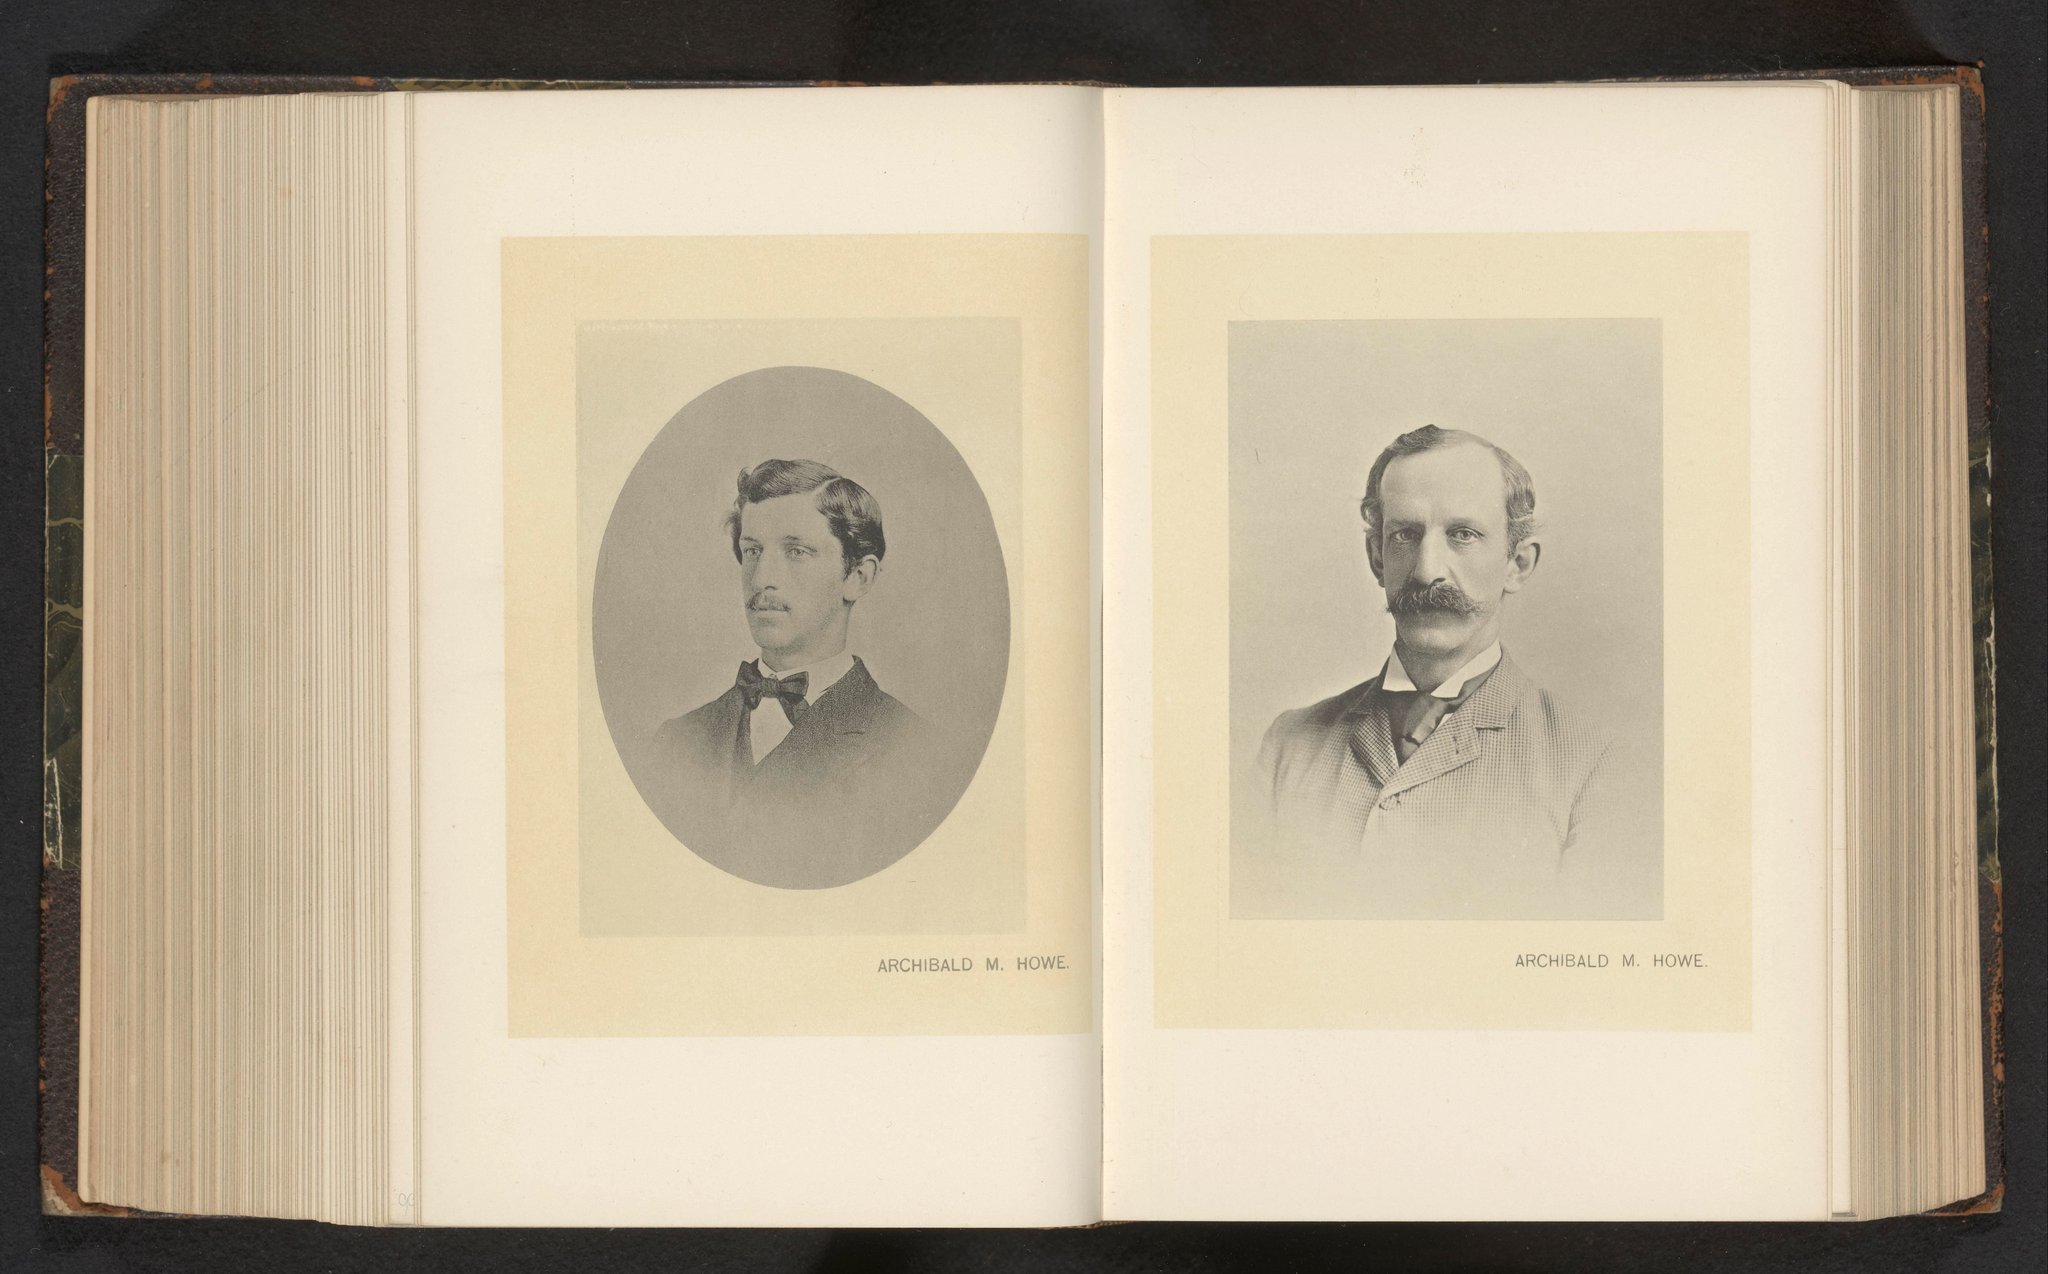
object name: page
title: Archibald M. Howe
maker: Anonymous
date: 1869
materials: paper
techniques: photoaquatint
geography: boston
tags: lawyer, attorney at law